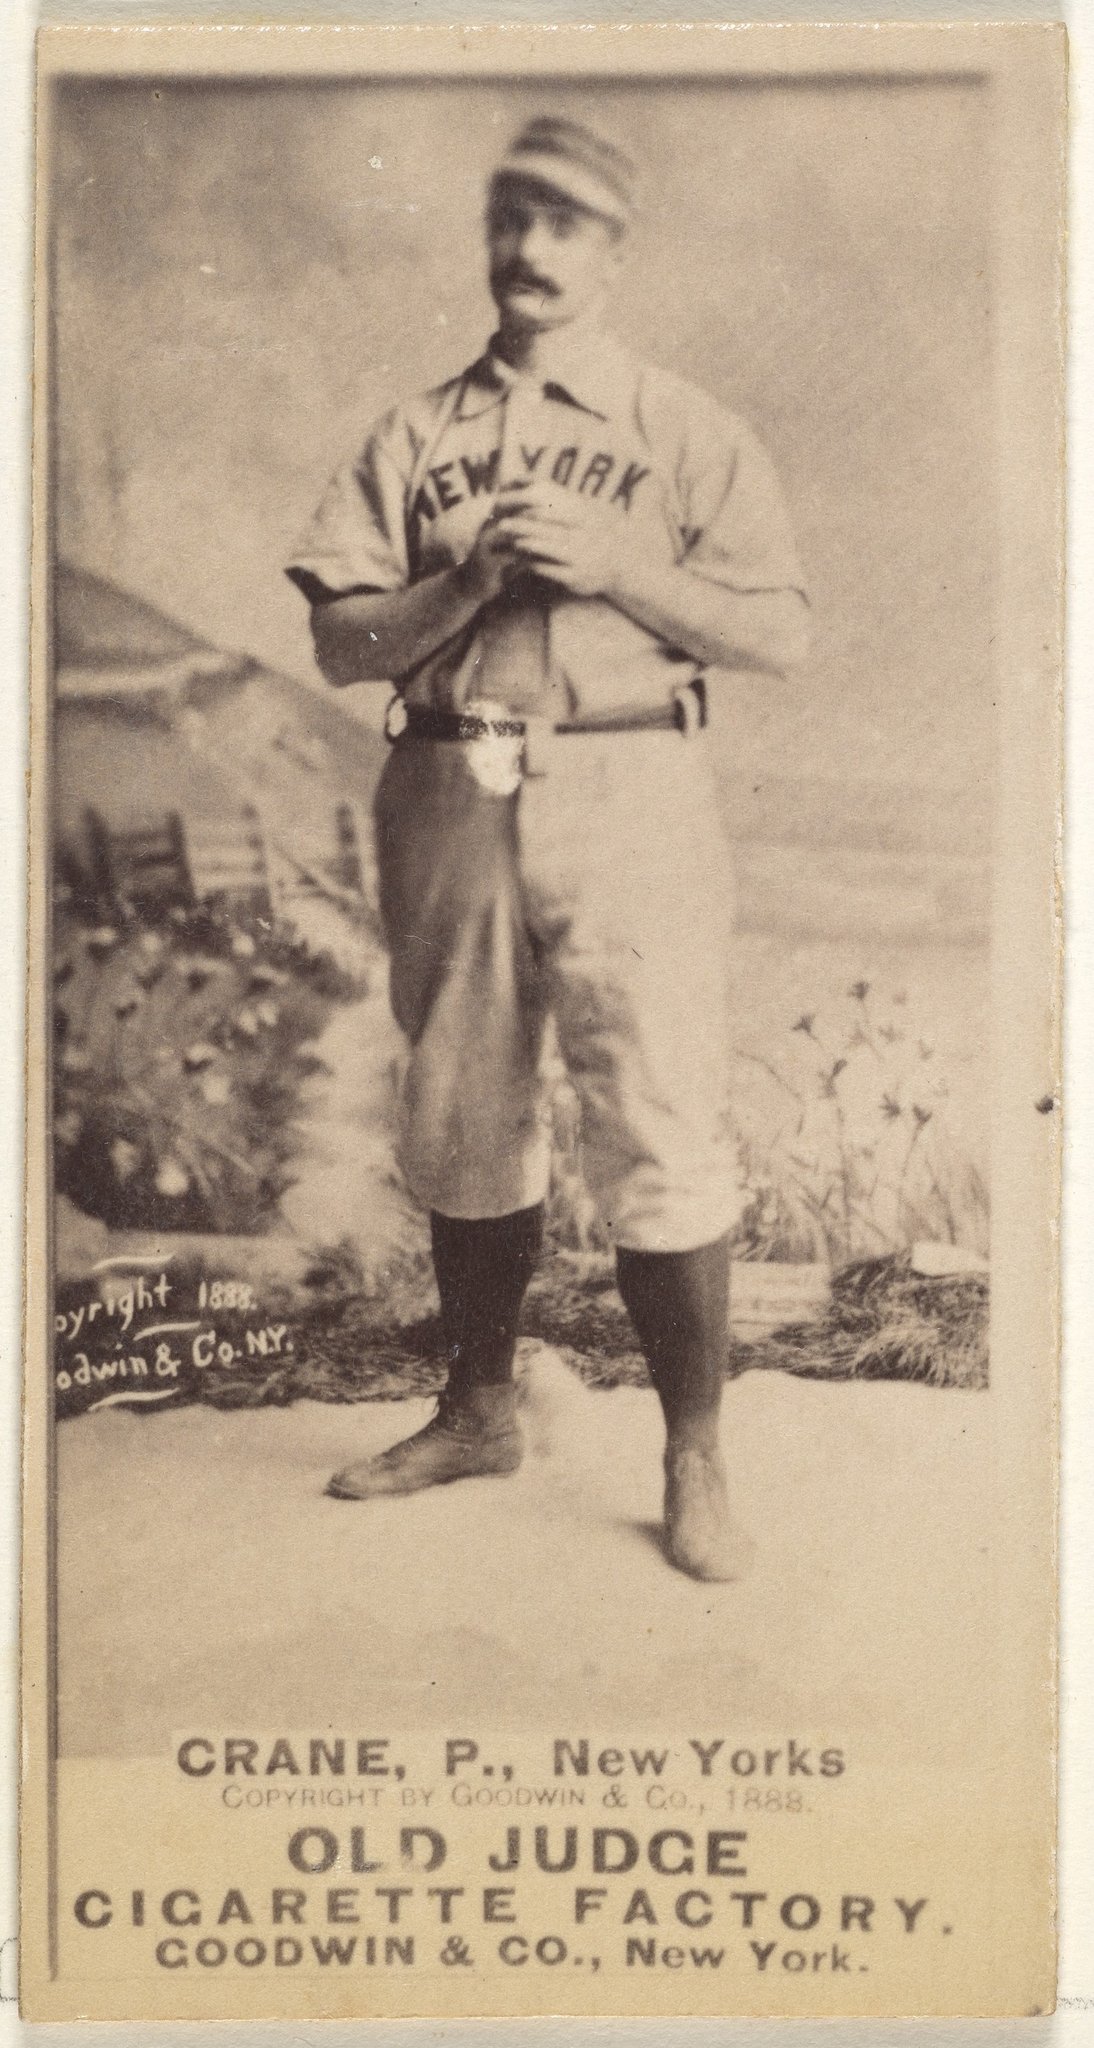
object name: baseball card, photograph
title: Ed Crane, Pitcher, New York, from the Old Judge series (N172) for Old Judge Cigarettes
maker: goodwin & company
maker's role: publisher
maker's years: 1850-1950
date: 1888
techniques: albumen silver print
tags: men,portraits,baseball,athletes